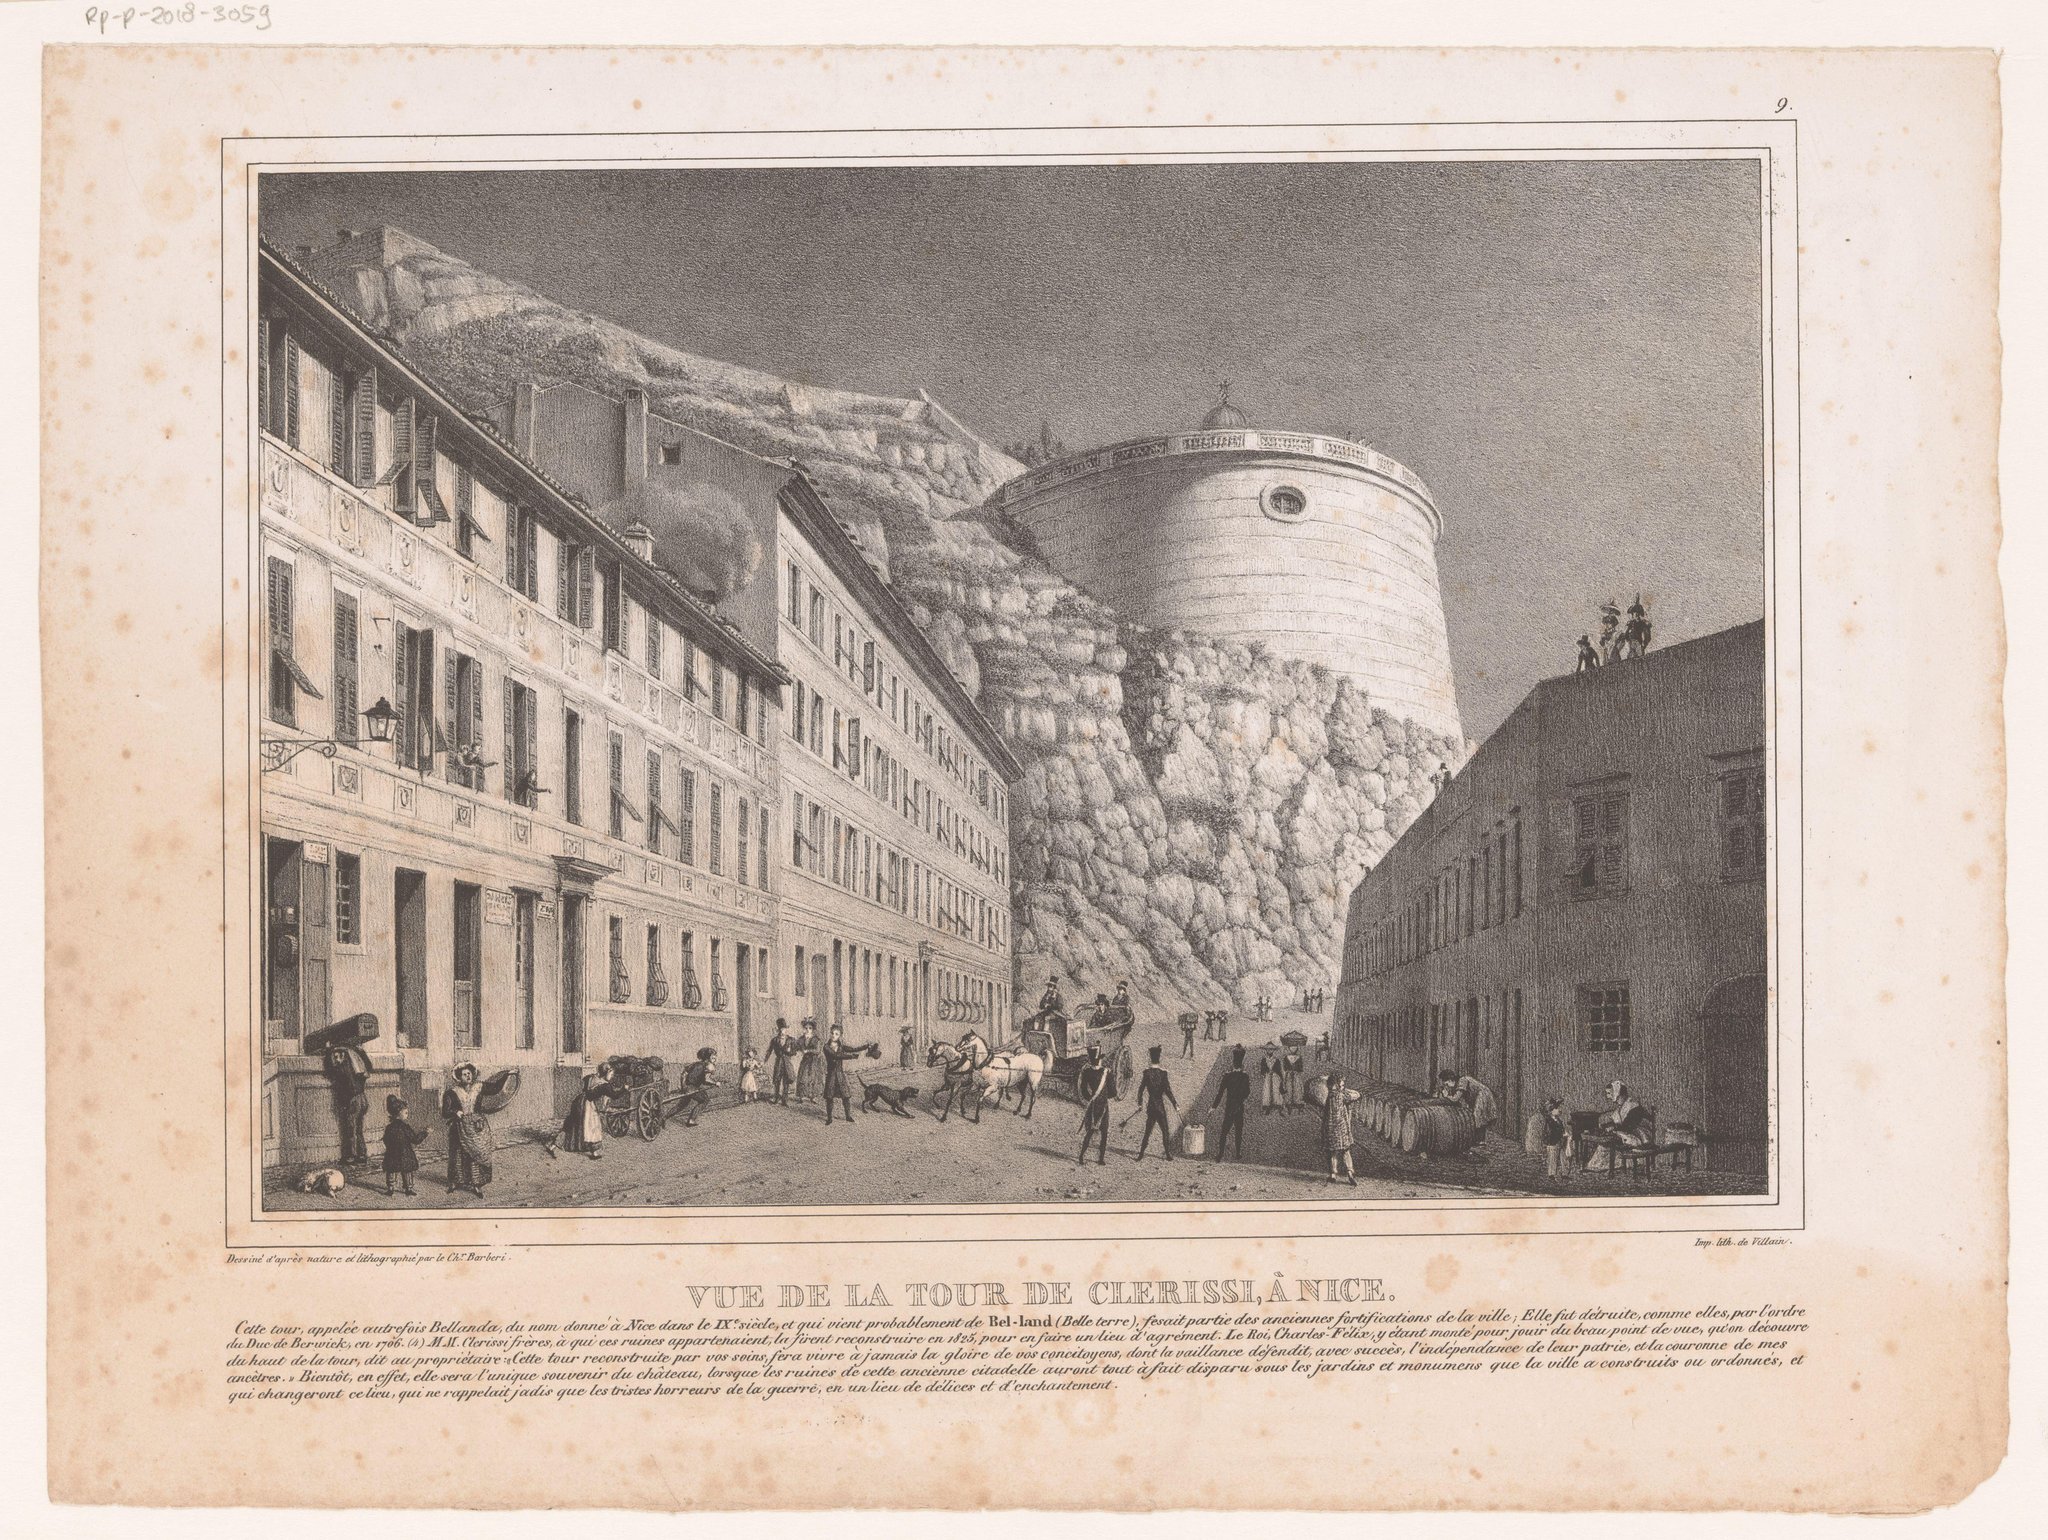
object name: print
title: Vue de la tour de Clerissi, à Nice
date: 1836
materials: paper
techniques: lithograph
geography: nice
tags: fortified house in city, street, tower (of house or building)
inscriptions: collector's mark: Lugt 2228